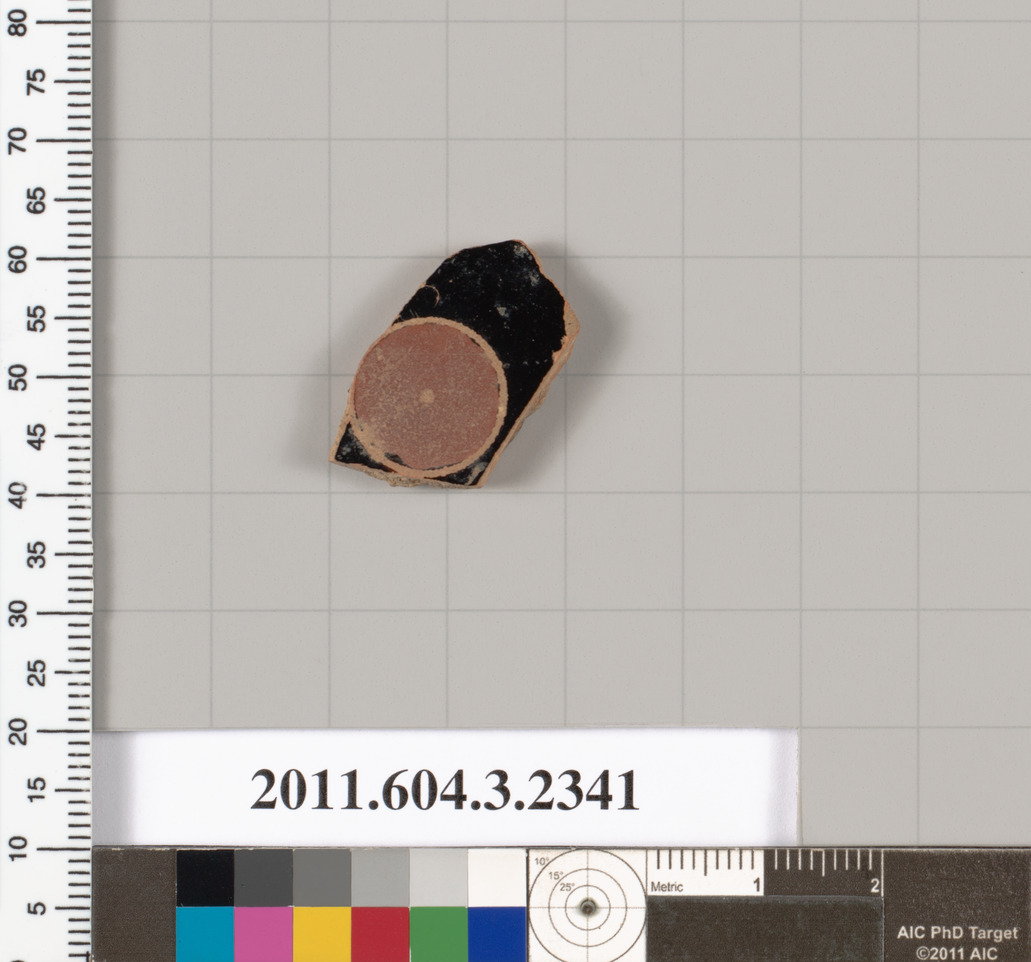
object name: kylix fragment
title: Terracotta fragment of a kylix: eye-cup (drinking cup)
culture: greek, attic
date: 540-520 BCE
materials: terracotta